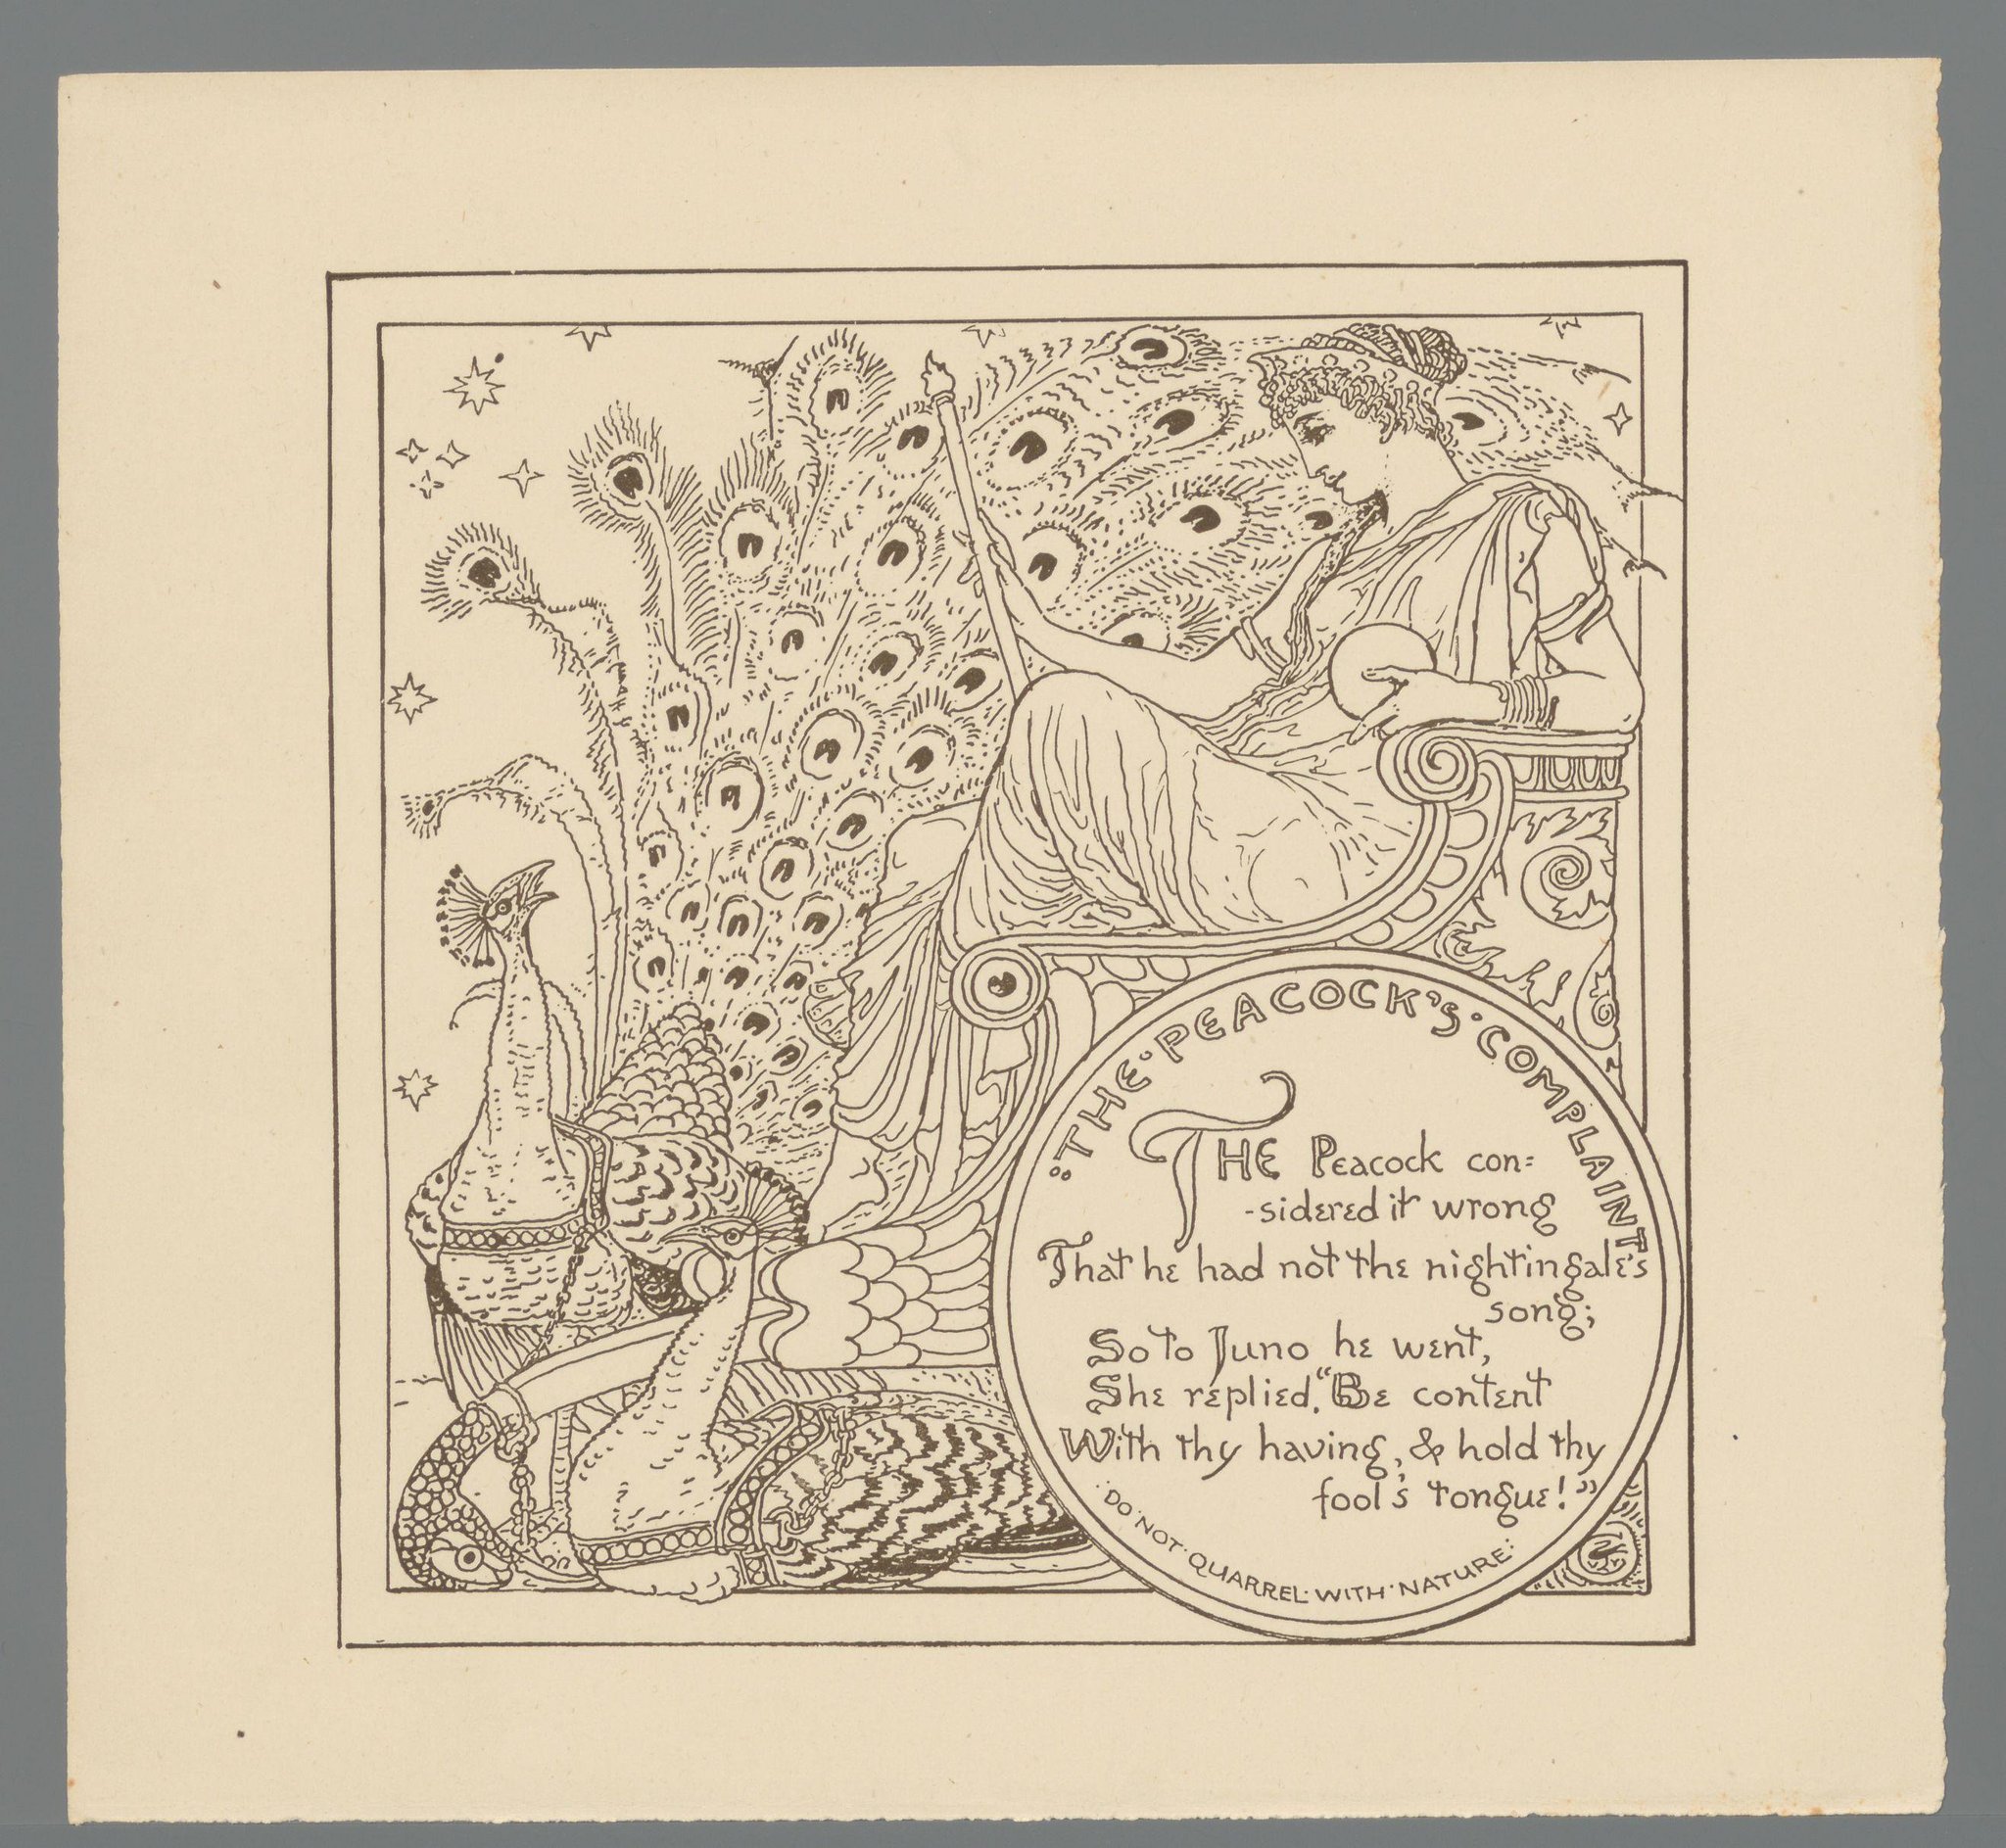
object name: print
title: The peacock's complaint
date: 1887-1927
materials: paper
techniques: engraving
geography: london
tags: (story of) juno (hera), throne, ornamental birds: peacock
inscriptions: collector's mark: Lugt 2228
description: Prent uit: Walter Crane's painting book. Londen: Routledge & Sons, 1887. Of een latere uitgave. Dit boek bevat twaalf voorstellingen die in kleur en lijntekening zijn gedrukt om te gebruiken als (in)kleurboek. De voorstellingen zijn afkomstig uit eerdere werken van Crane.